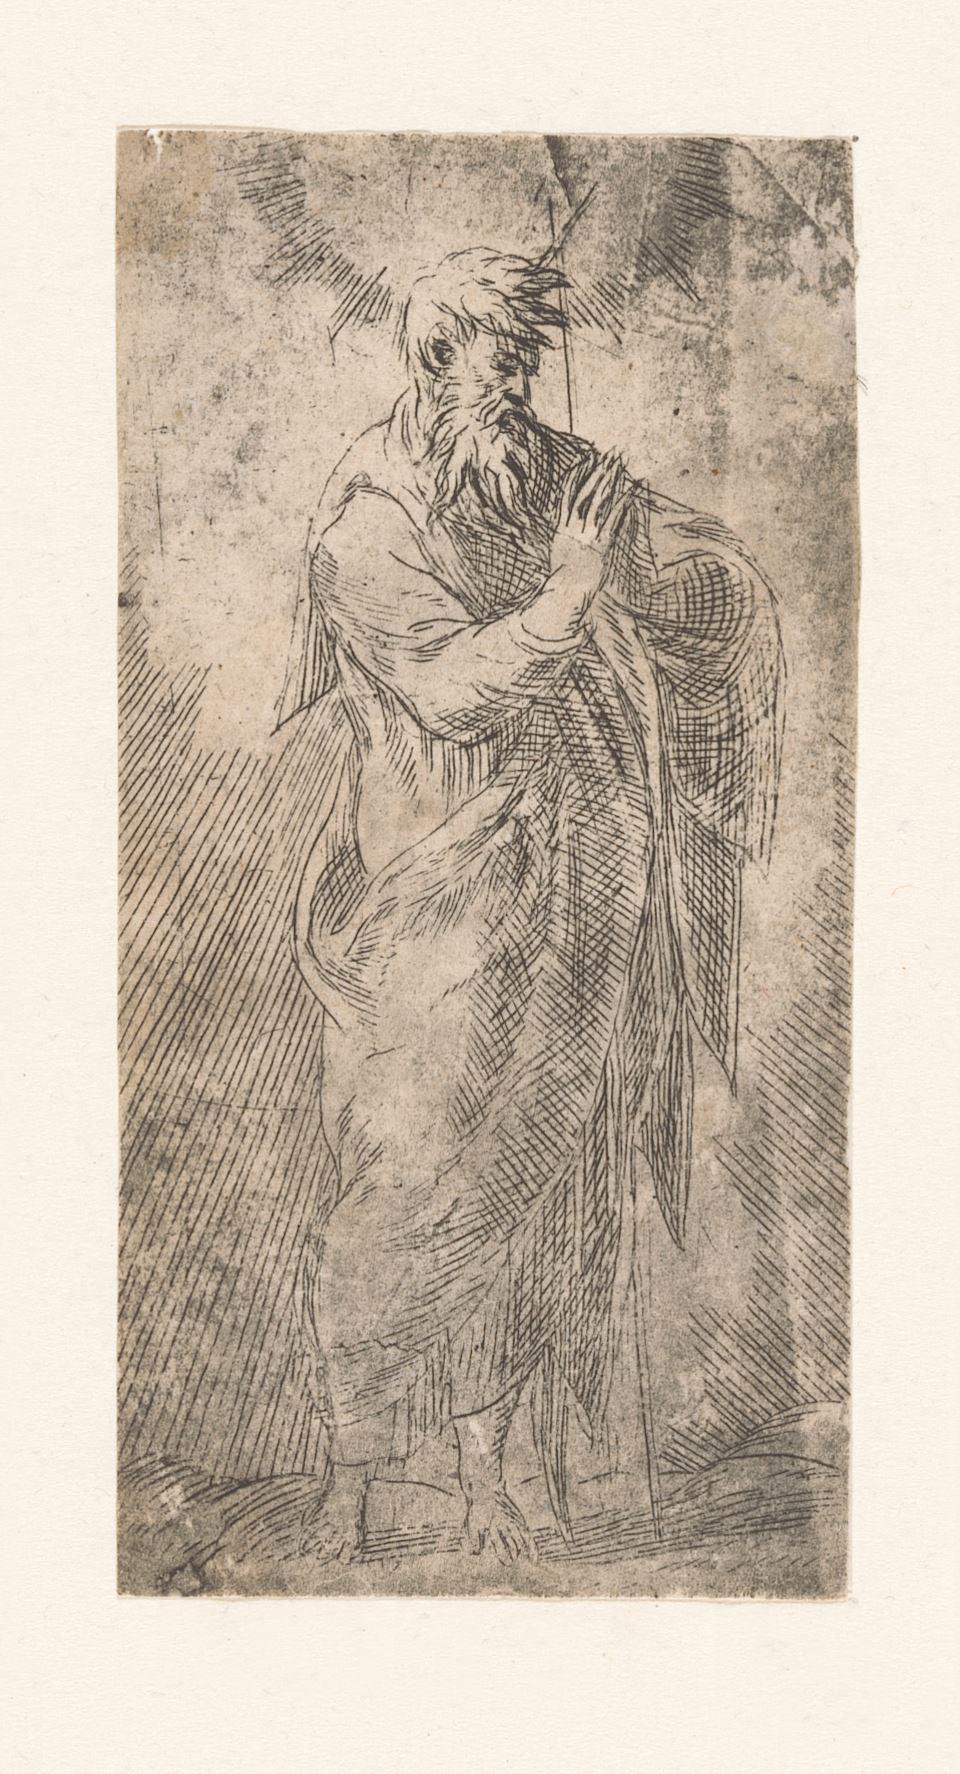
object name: print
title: De heilige Filippus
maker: schiavone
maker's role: draughtsman, painter, print maker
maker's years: 1500-1563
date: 1532-1563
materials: paper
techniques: etching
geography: italy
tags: the apostle philip; possible attributes: book, cross, dish with snake, lance, scroll, stone, sword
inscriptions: collector's mark: Lugt 240, collector's mark: Lugt 2228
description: Deze prent maakt deel uit van een reeks van 14 prenten van Christus, Paulus en de twaalf apostelen. De reeks prenten is gekopieerd naar de reeks chiaroscuro houtsneden door Antonio da Trento of naar de originele houtsneden door Parmigianino.